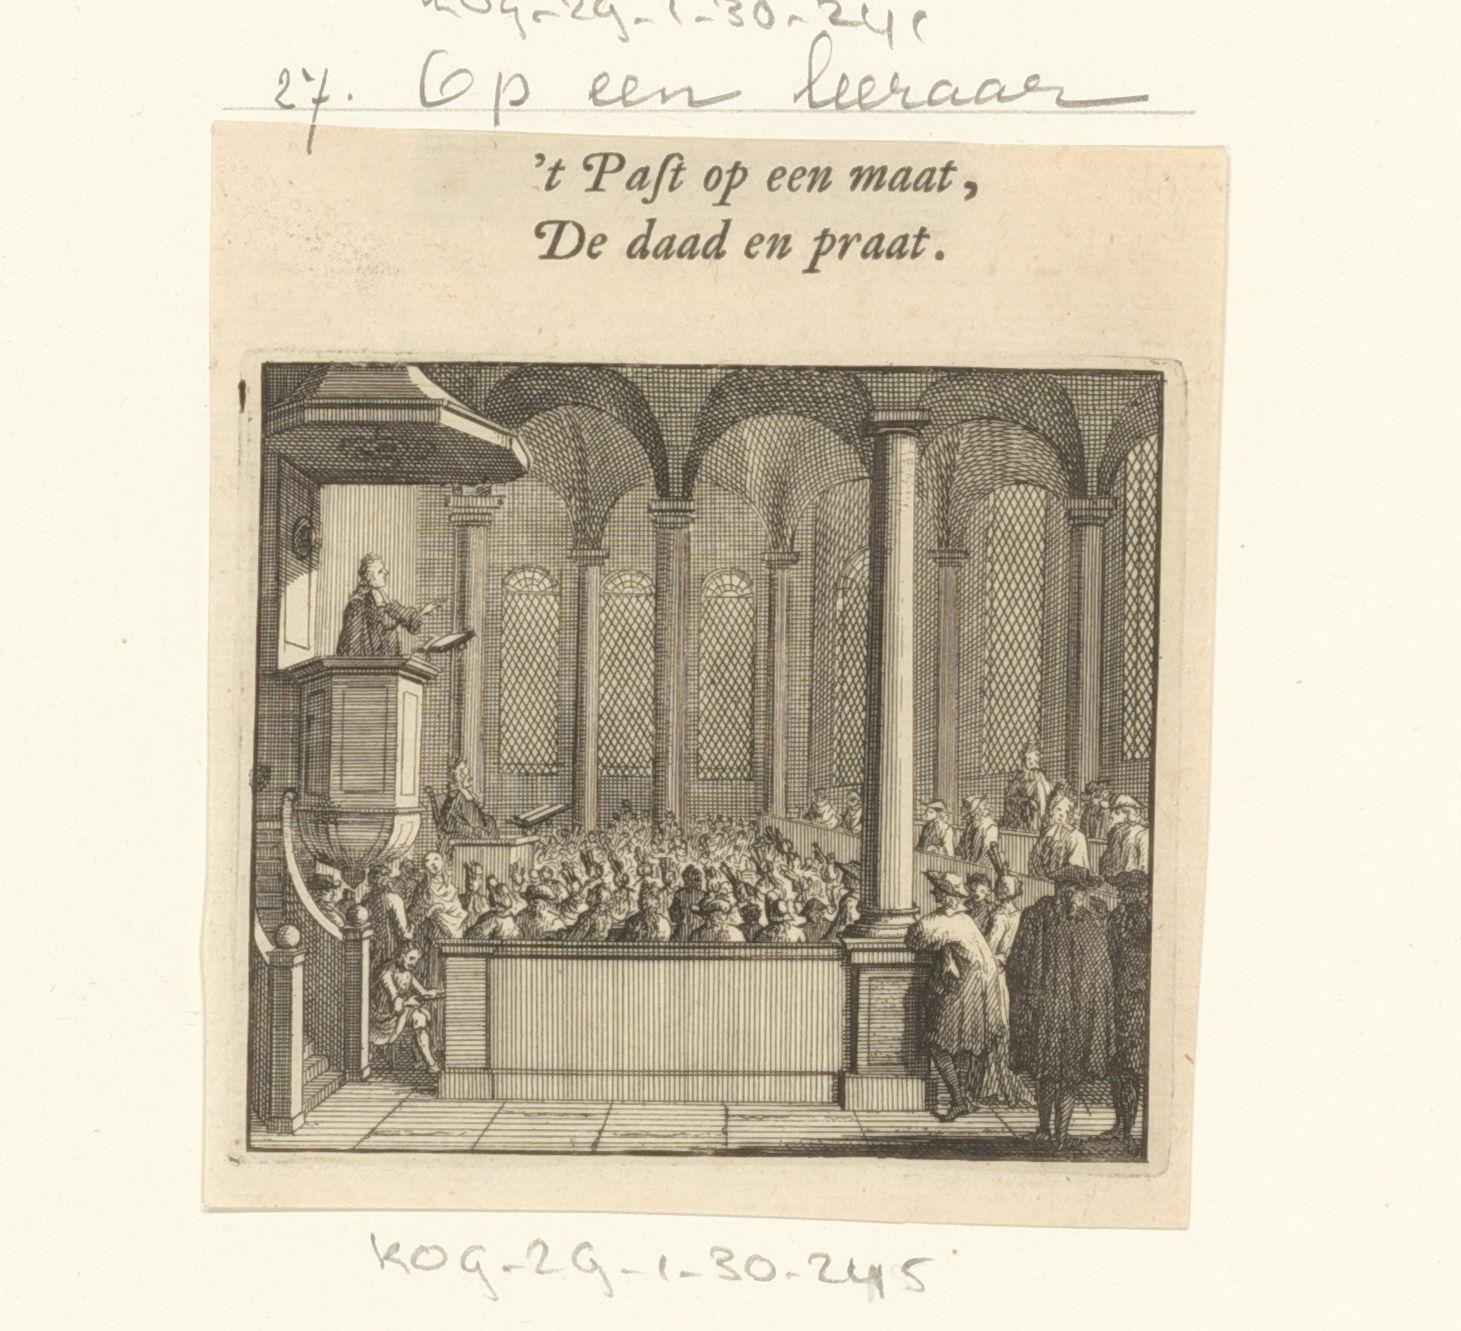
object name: print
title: 't Past op een maat, De daad en praat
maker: cornelis huyberts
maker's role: print maker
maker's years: 1669-1709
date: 1725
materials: paper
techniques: etching, letterpress printing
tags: protestant churches and denominations, priests ~ hierarchy of priests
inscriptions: collector's mark: Lugt 1641, stamp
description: Prent uit: Graauwhart, Hendrik. Voorbeeldelyke zeede-lessen, genoomen uyt den eersten toestand des werelds (...). Amsterdam: Johannes Ratelband, 1725. Prent ook gebruikt voor eerdere en (1709) latere uitgave (1756, 1761 en 1764).